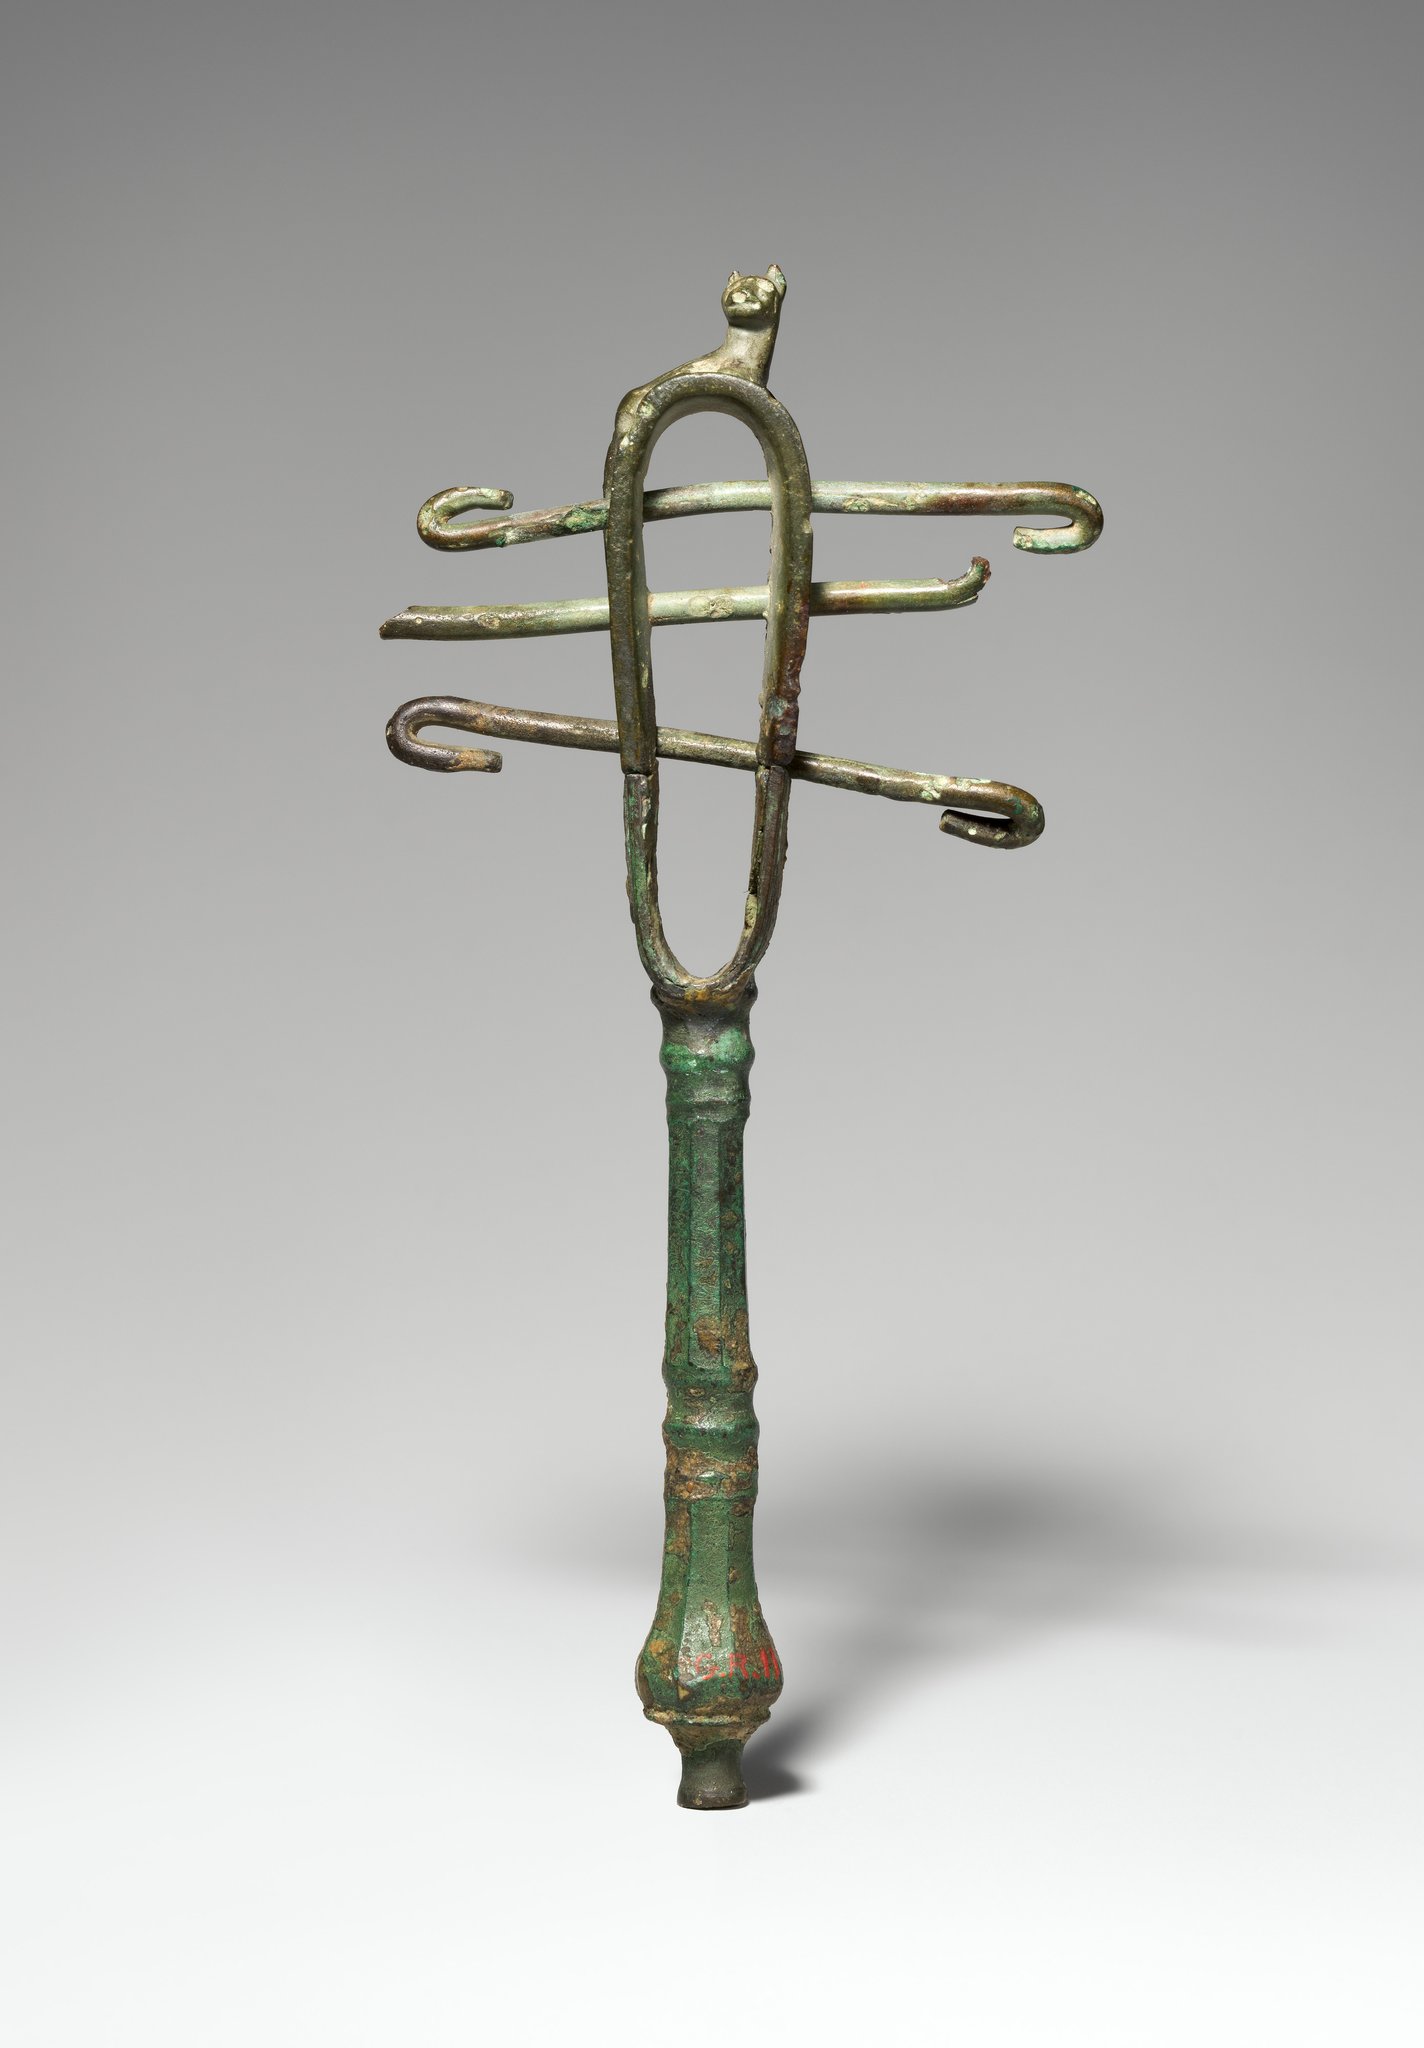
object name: sistrum with cat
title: Bronze sistrum (rattle)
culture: roman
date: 1-300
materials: bronze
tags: cats